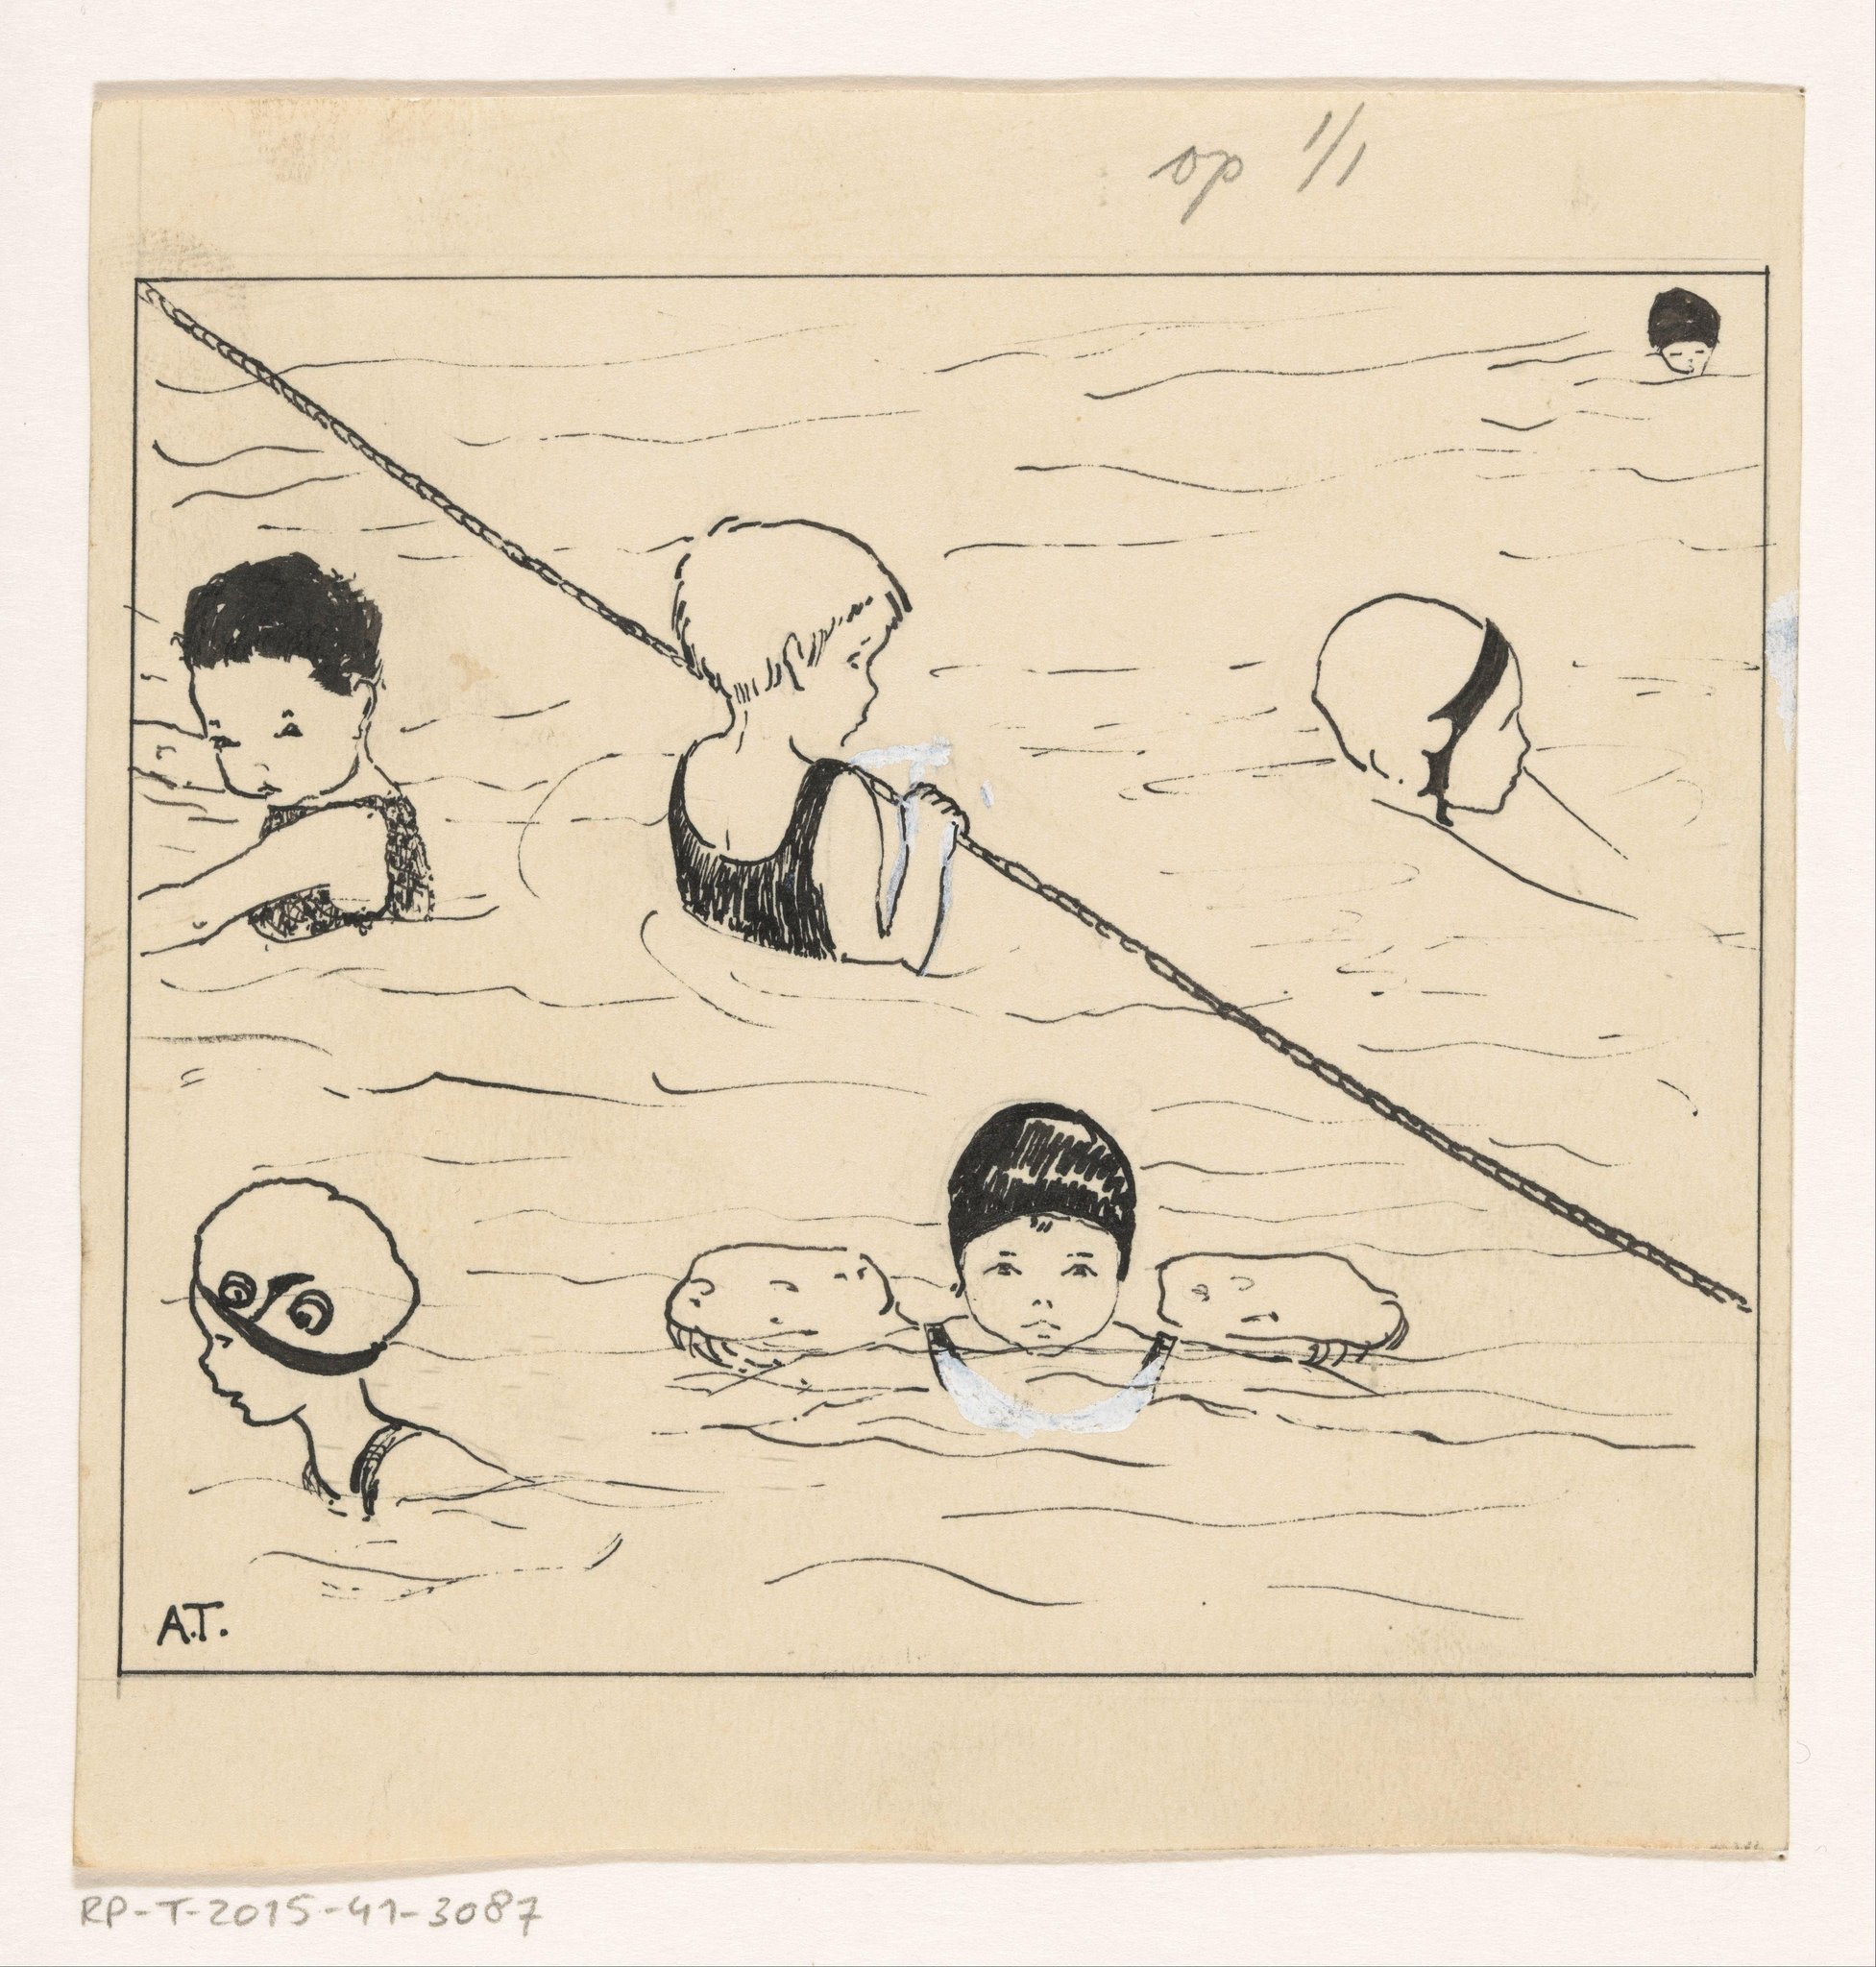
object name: boekillustratie ontwerp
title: Kinderen in een zwembad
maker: a. tinbergen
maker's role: draughtsman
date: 1925-1935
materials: paint, ink, paper, pencil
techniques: brush, pen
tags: child, swimming (movement in water)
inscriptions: collector's mark: Lugt 2228a, :, monogram: ‘A.T.’